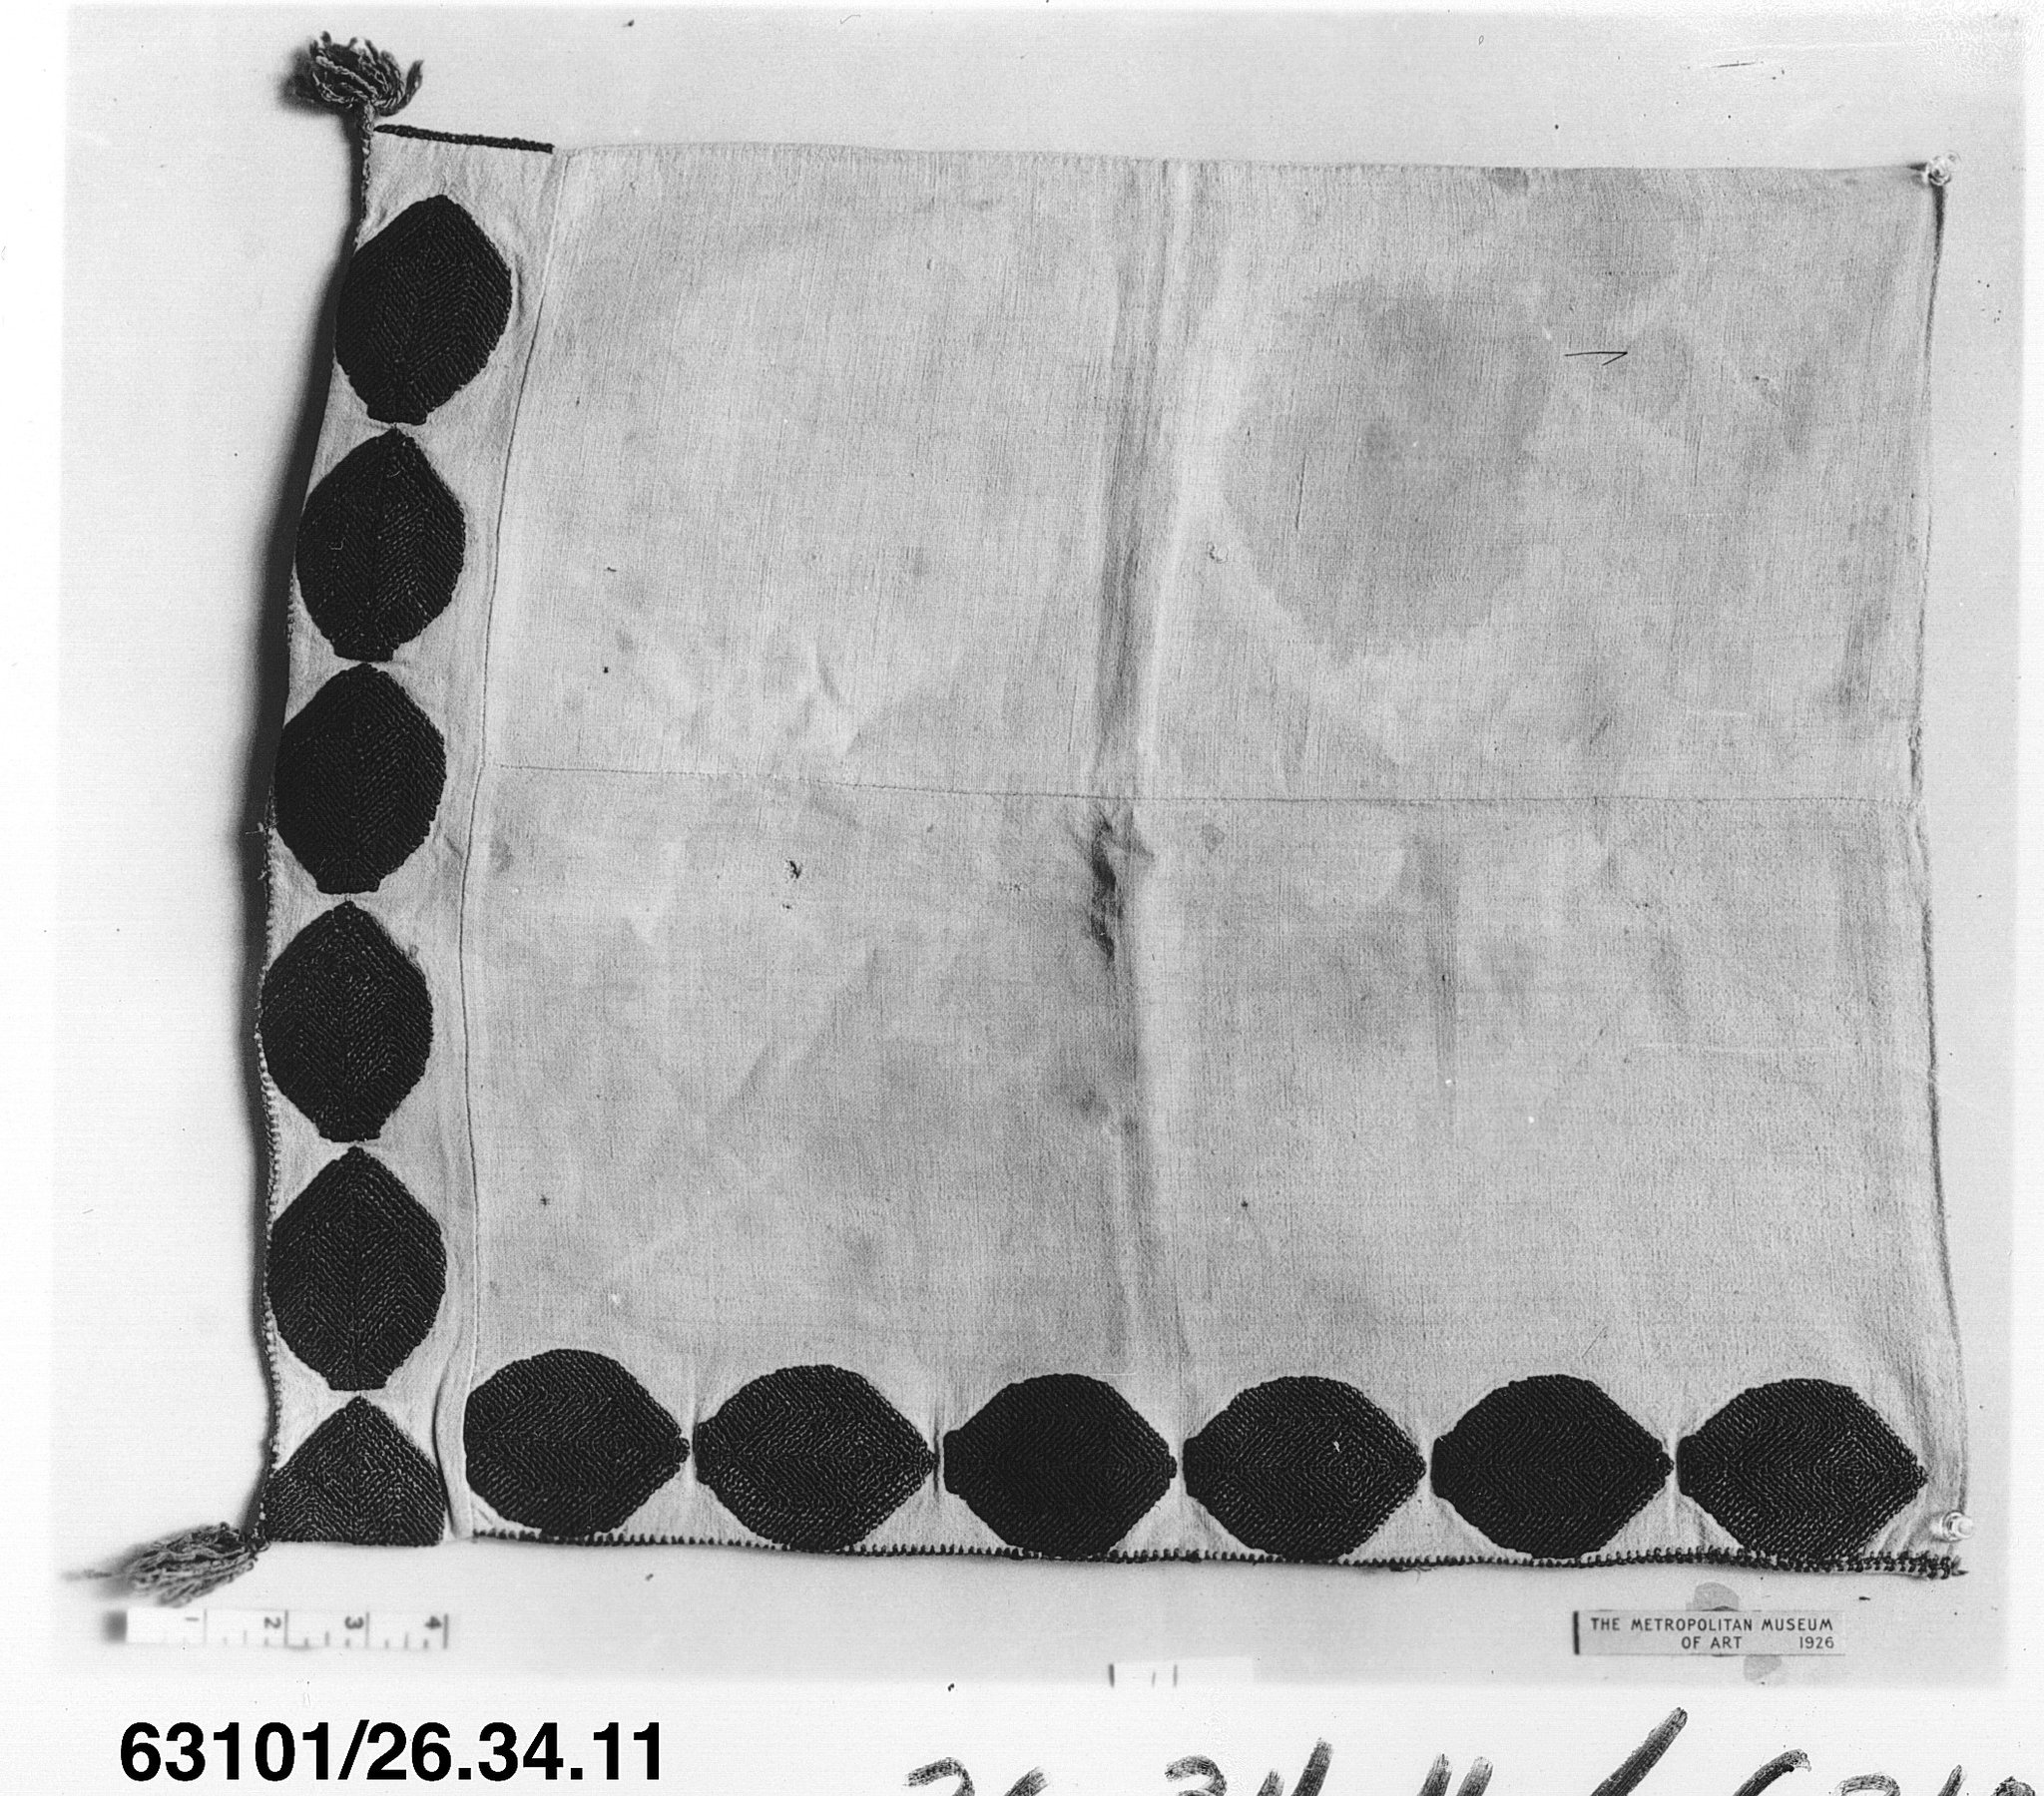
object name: saddle bag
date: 1701-1800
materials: linen, silk